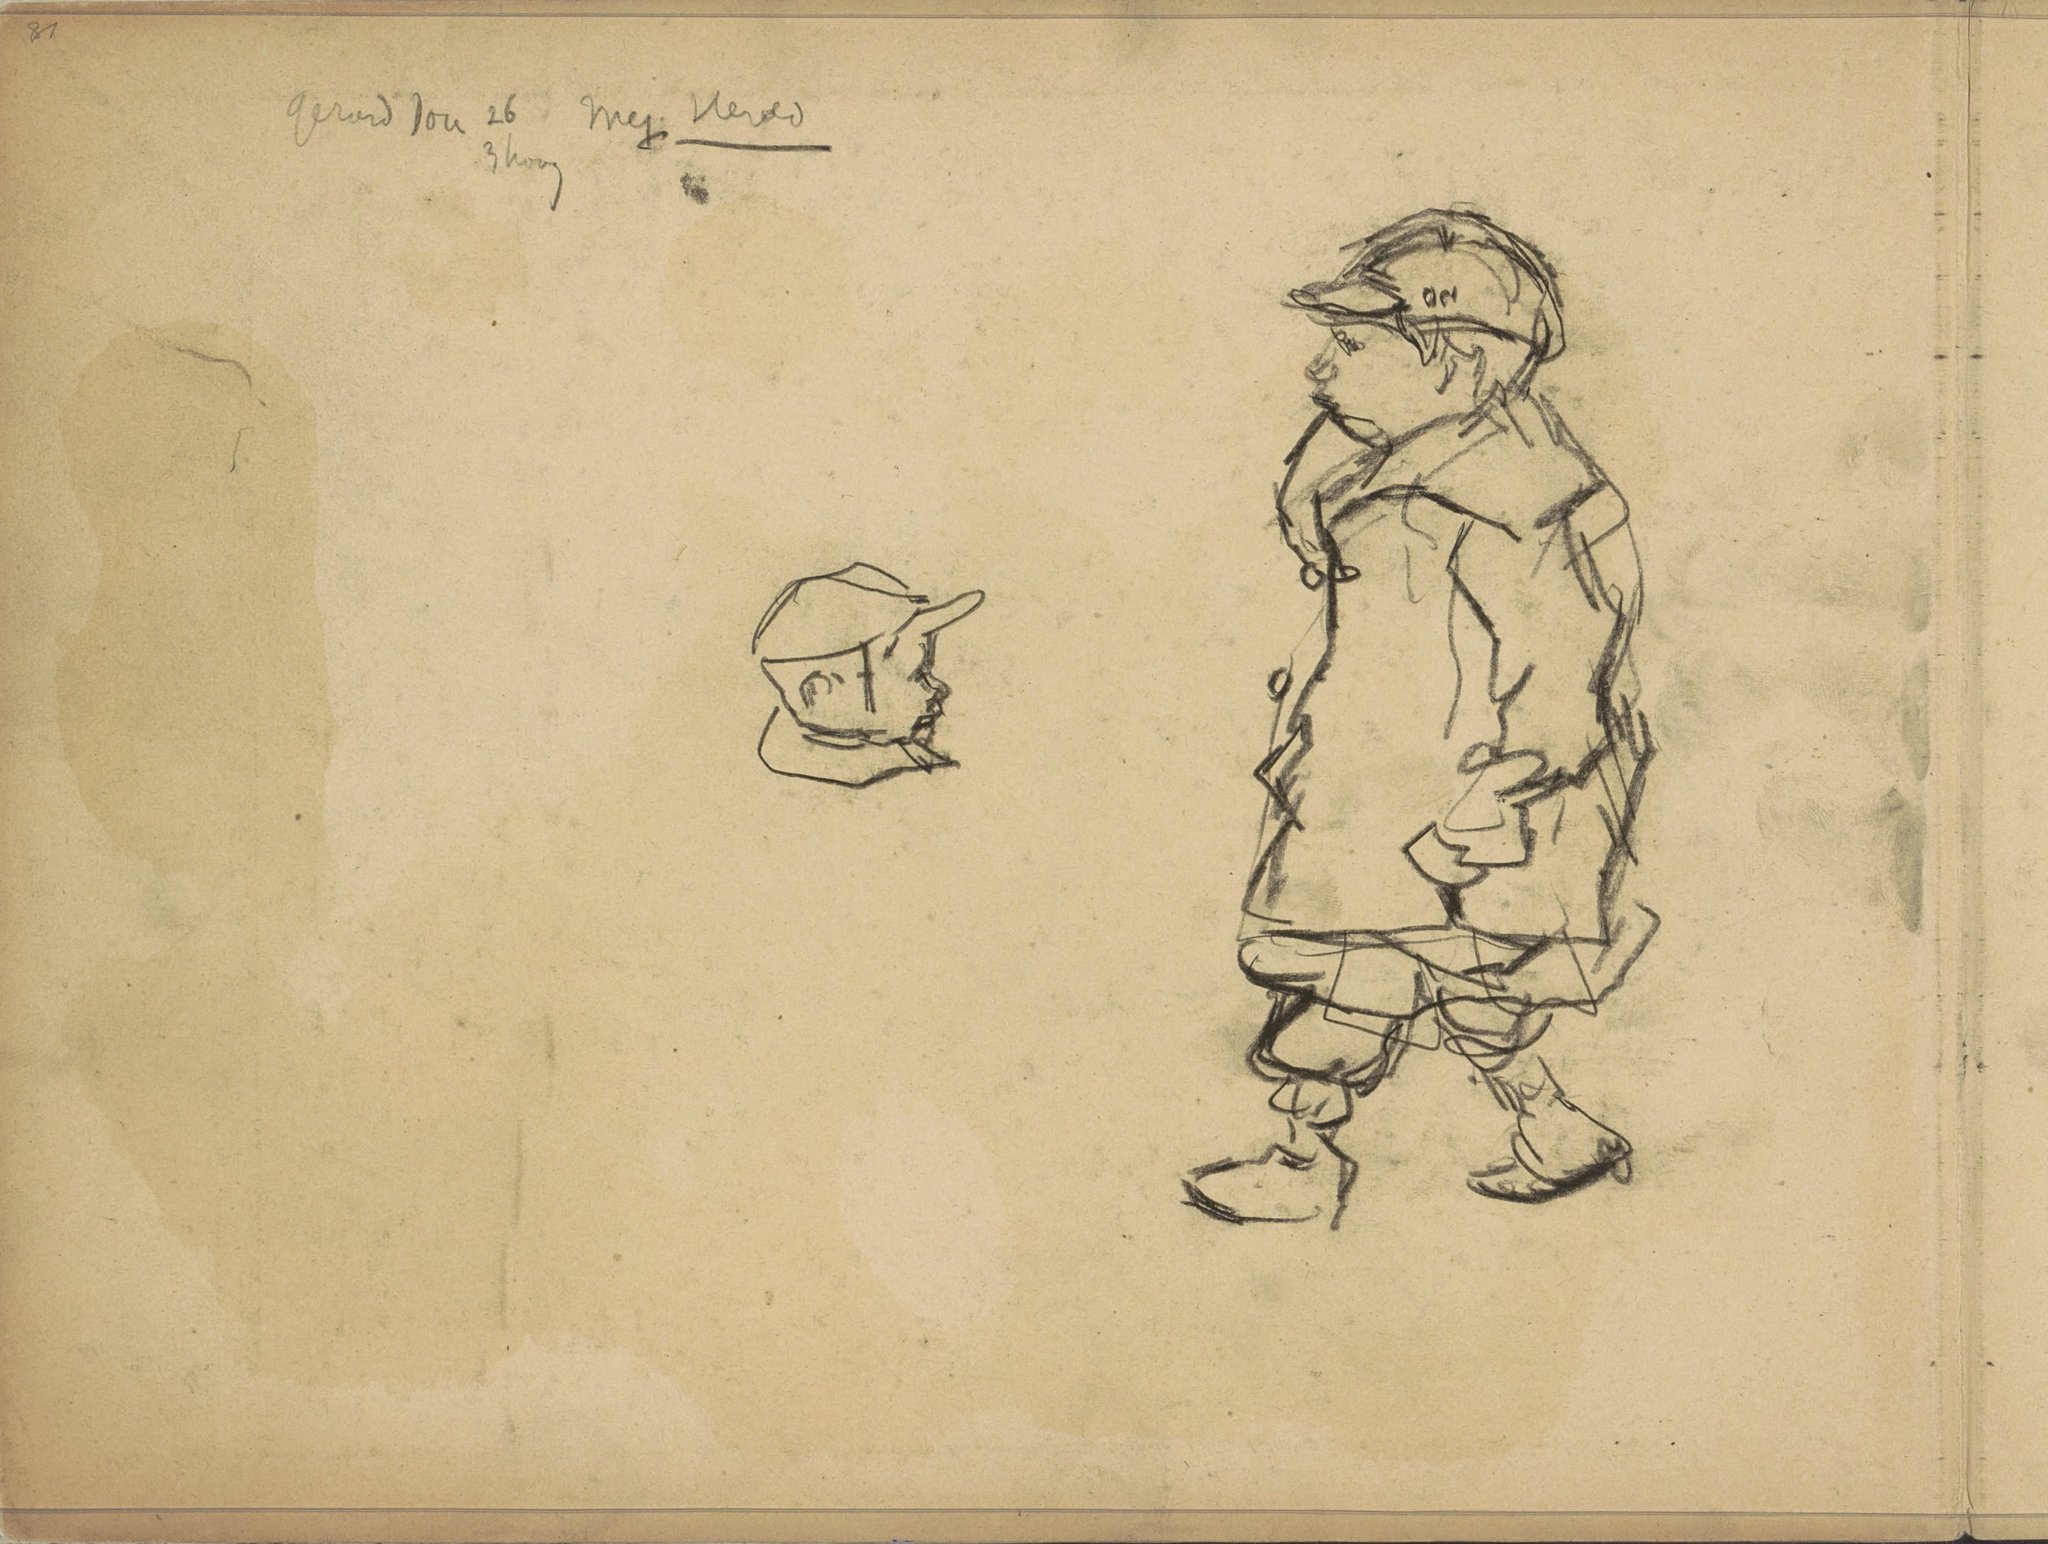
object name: sketchbook leaf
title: Jongen met pet en een jongenshoofd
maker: isaac israels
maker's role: draughtsman, painter, print maker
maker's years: 1865-1934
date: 1875-1934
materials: chalk, paper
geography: the hague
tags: head (human), boy (child between toddler and youth), head-gear: cap (+ men's clothes)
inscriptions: annotation: ‘Gerard Dou 26 mej. Herder[?] / 3 hoog’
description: Blad 17 recto uit schetsboek XIV met 17 bladen.